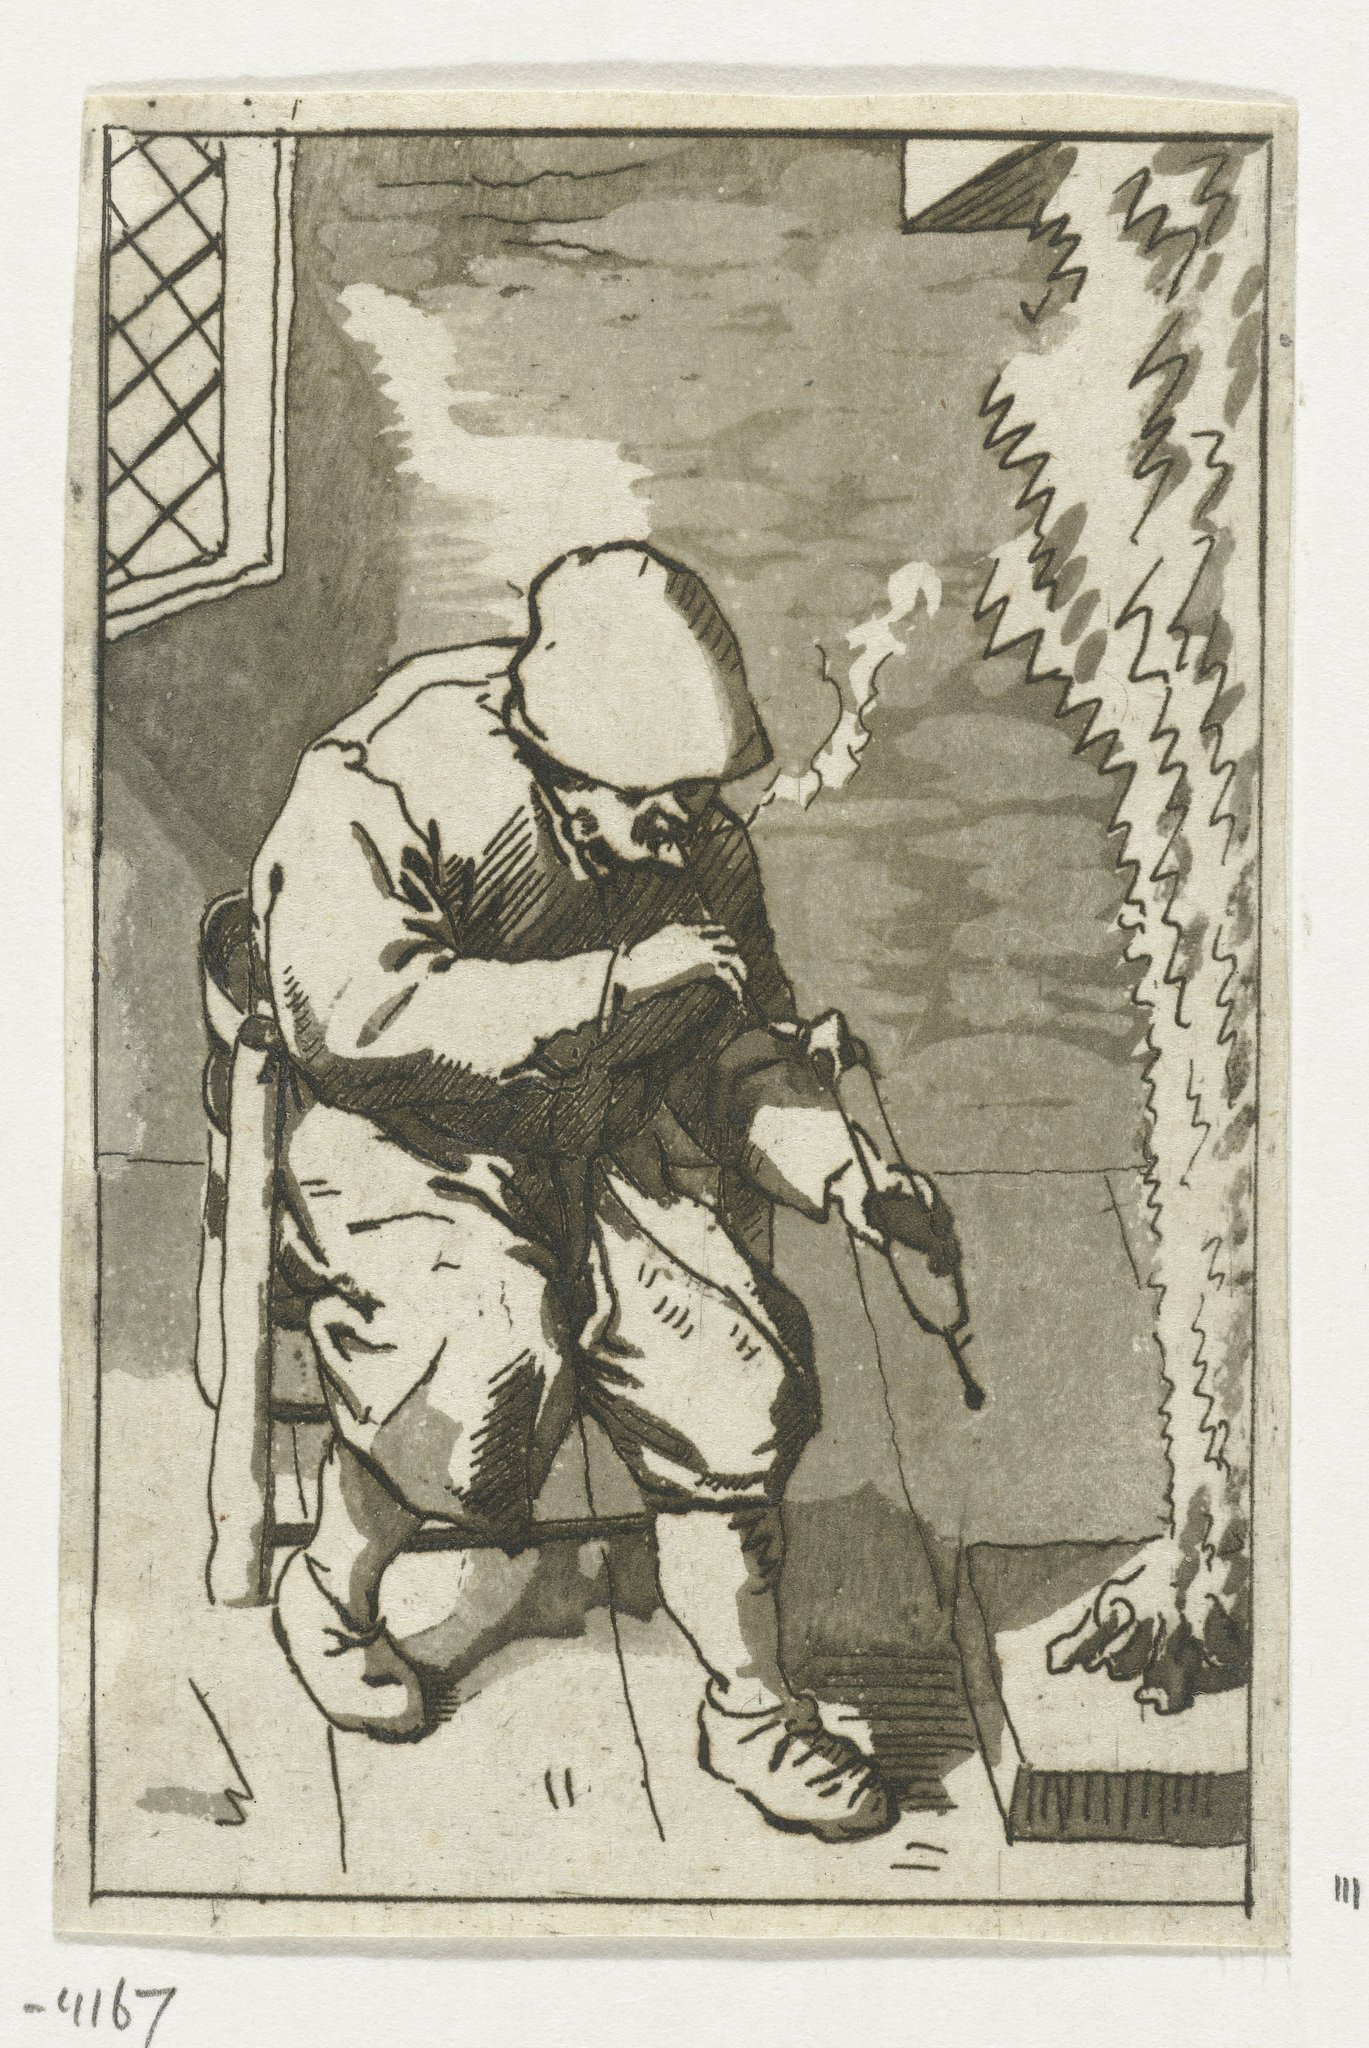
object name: print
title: Man steekt zijn pijp aan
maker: anthonie van den bos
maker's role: draughtsman, print maker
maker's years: 1763-1838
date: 1778-1838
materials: paper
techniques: aquatint, etching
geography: netherlands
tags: pipe ~ tobacco (+ taking (particular) foodstuffs: eating, drinking, smoking, chewing, etc.)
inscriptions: collector's mark: Lugt 2228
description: Een man zit bij het haardvuur en ontsteekt zijn pijp met een kooltje uit de haard.